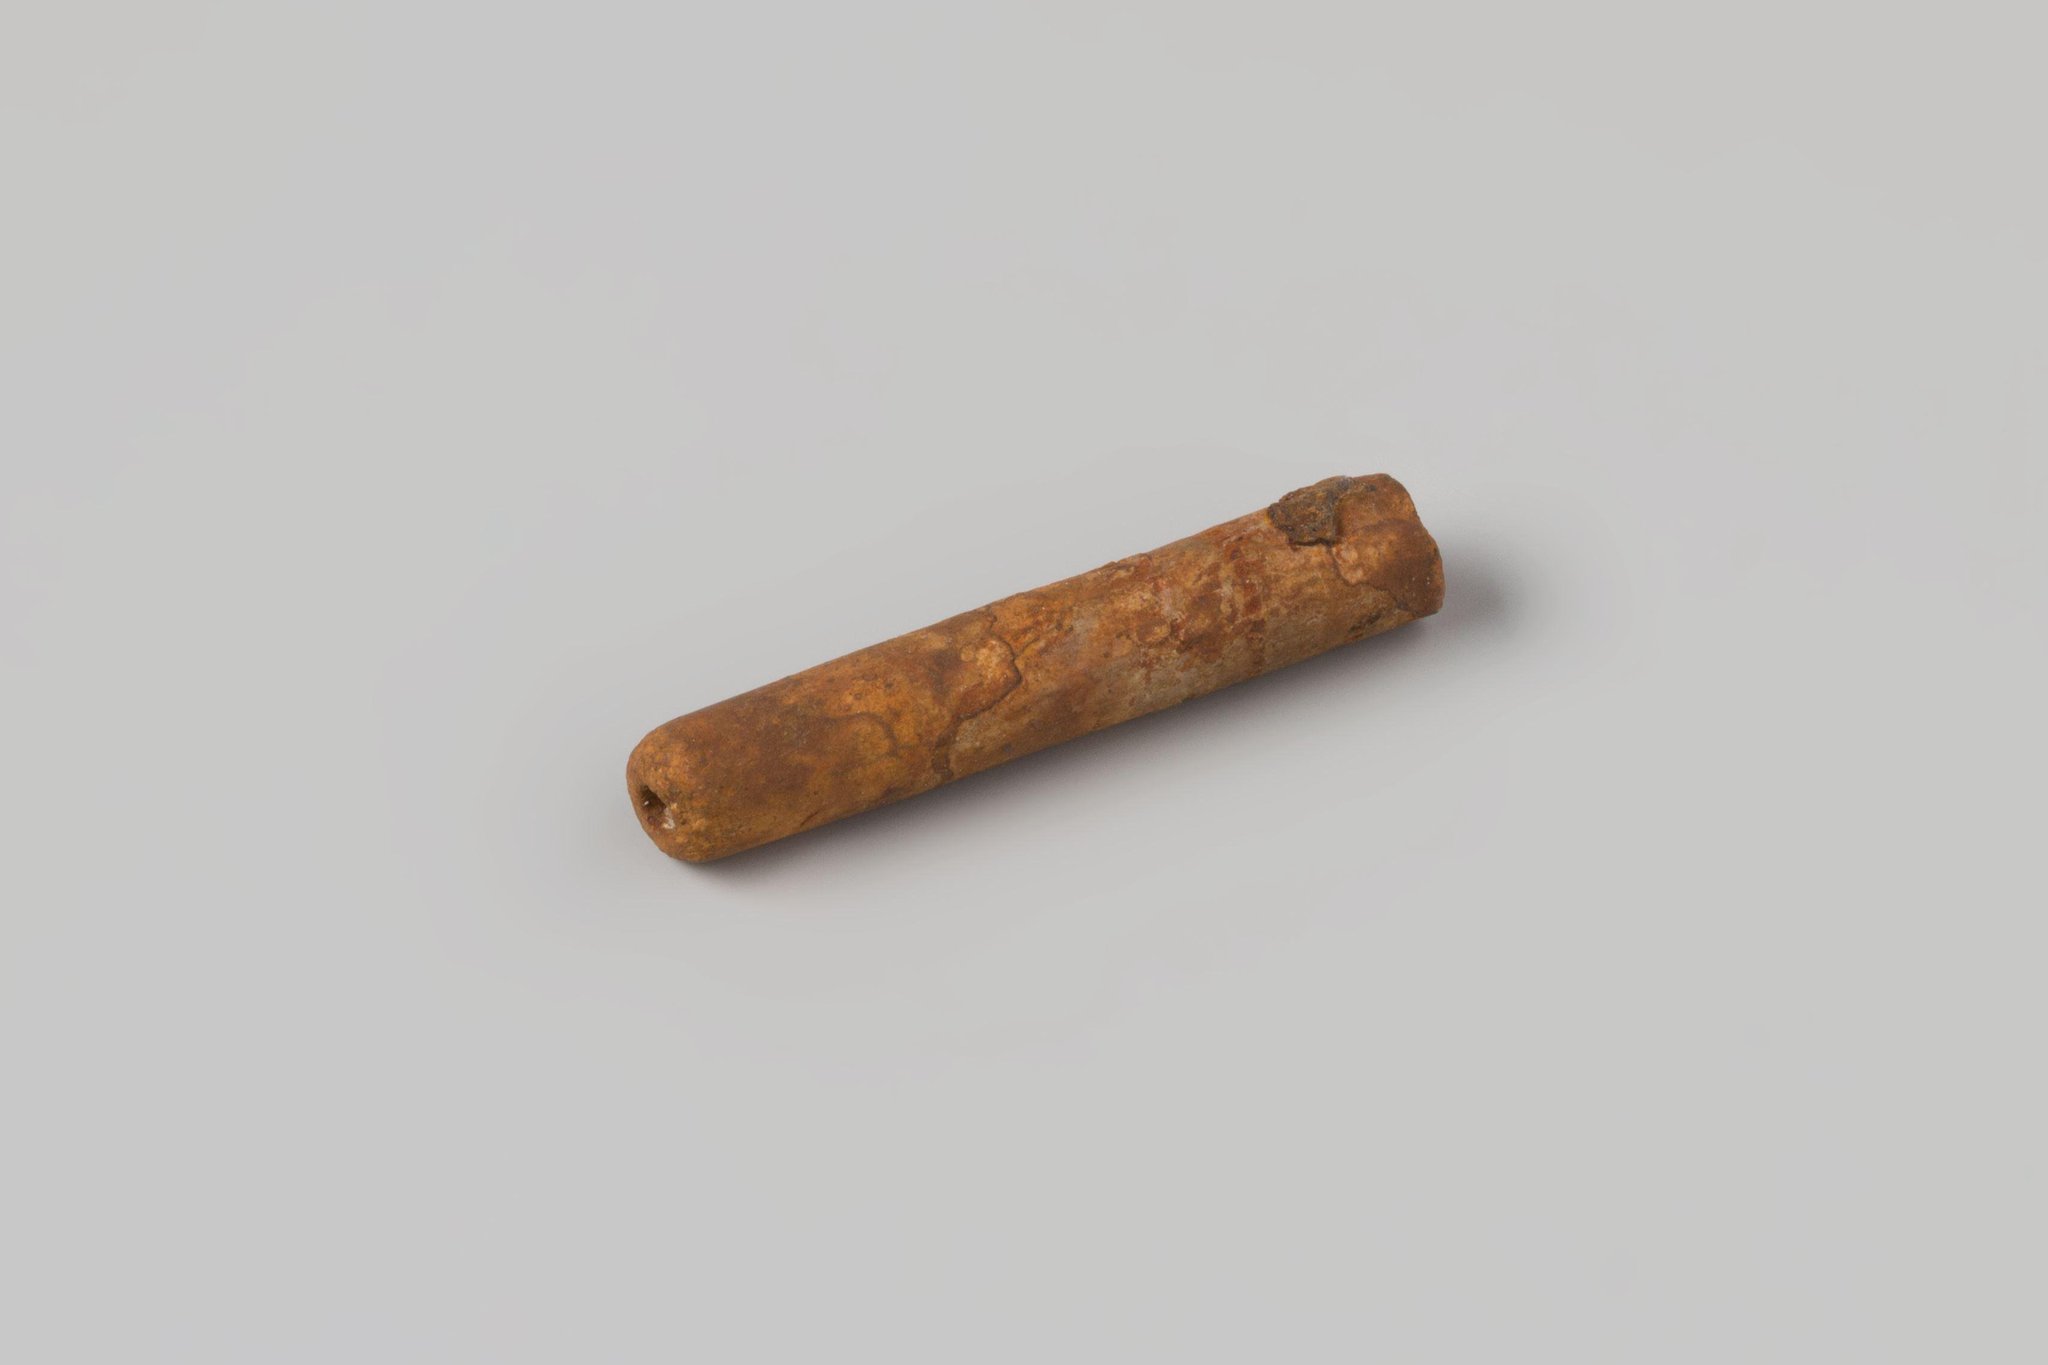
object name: pipe stem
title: Fragment pijpensteel uit het wrak van de Oost-Indiëvaarder Hollandia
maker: Anonymous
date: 1700-1743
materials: clay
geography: netherlands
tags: verenigde oostindische compagnie, hollandia (schip), annet